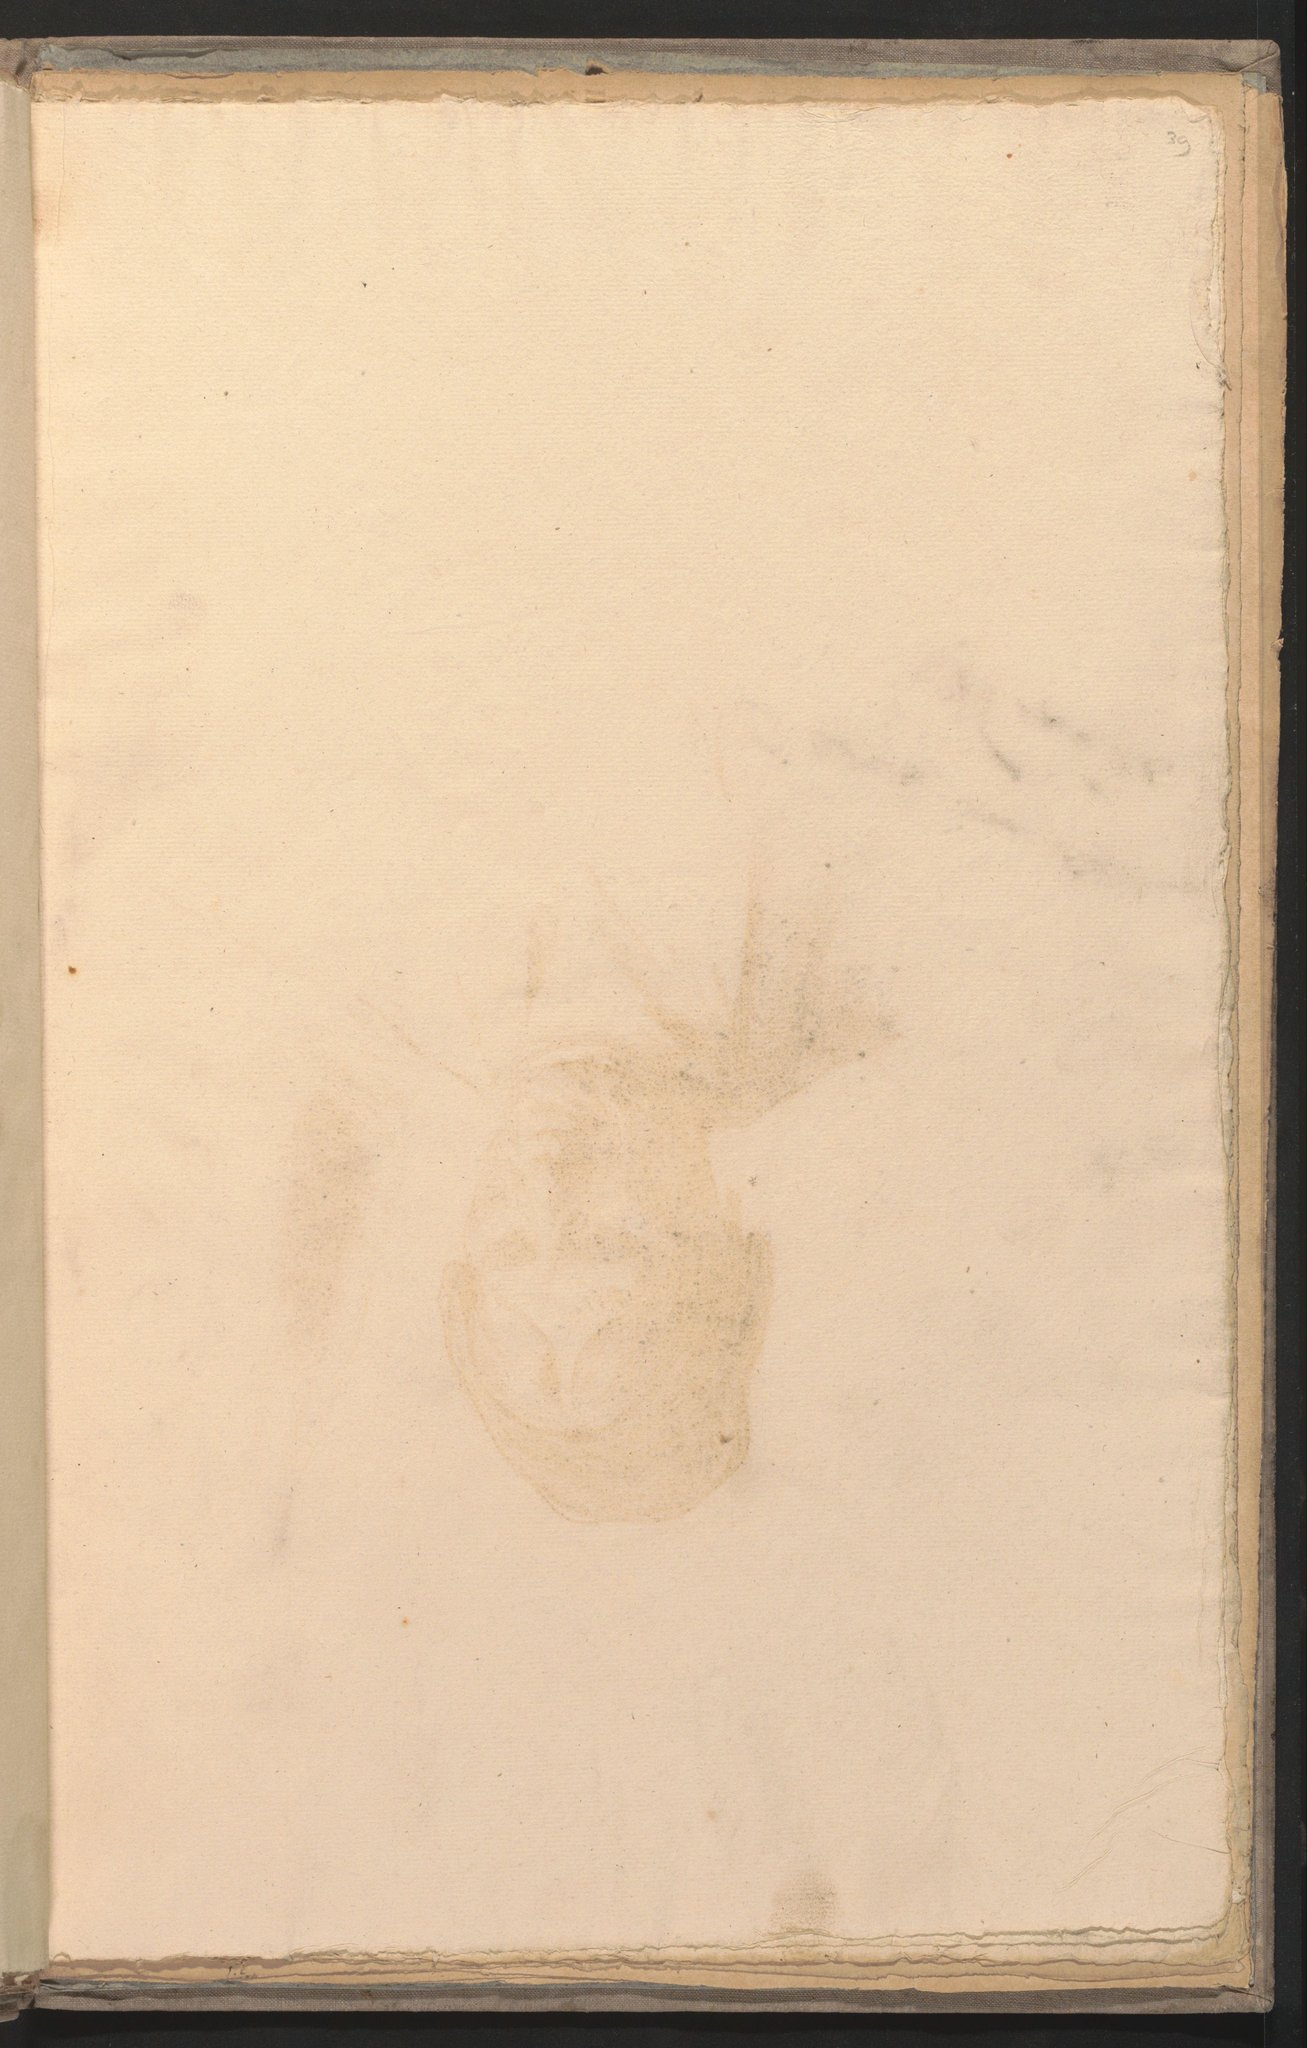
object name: sketchbook leaf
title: Abklatsch van de krijttekening op pagina 38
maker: willem witsen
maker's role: draughtsman, painter, print maker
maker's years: 1860-1923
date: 1886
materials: paper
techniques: printmaking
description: Pagina 39 uit een schetsboek met 38 bladen betekend rond de Ewijkshoeve.